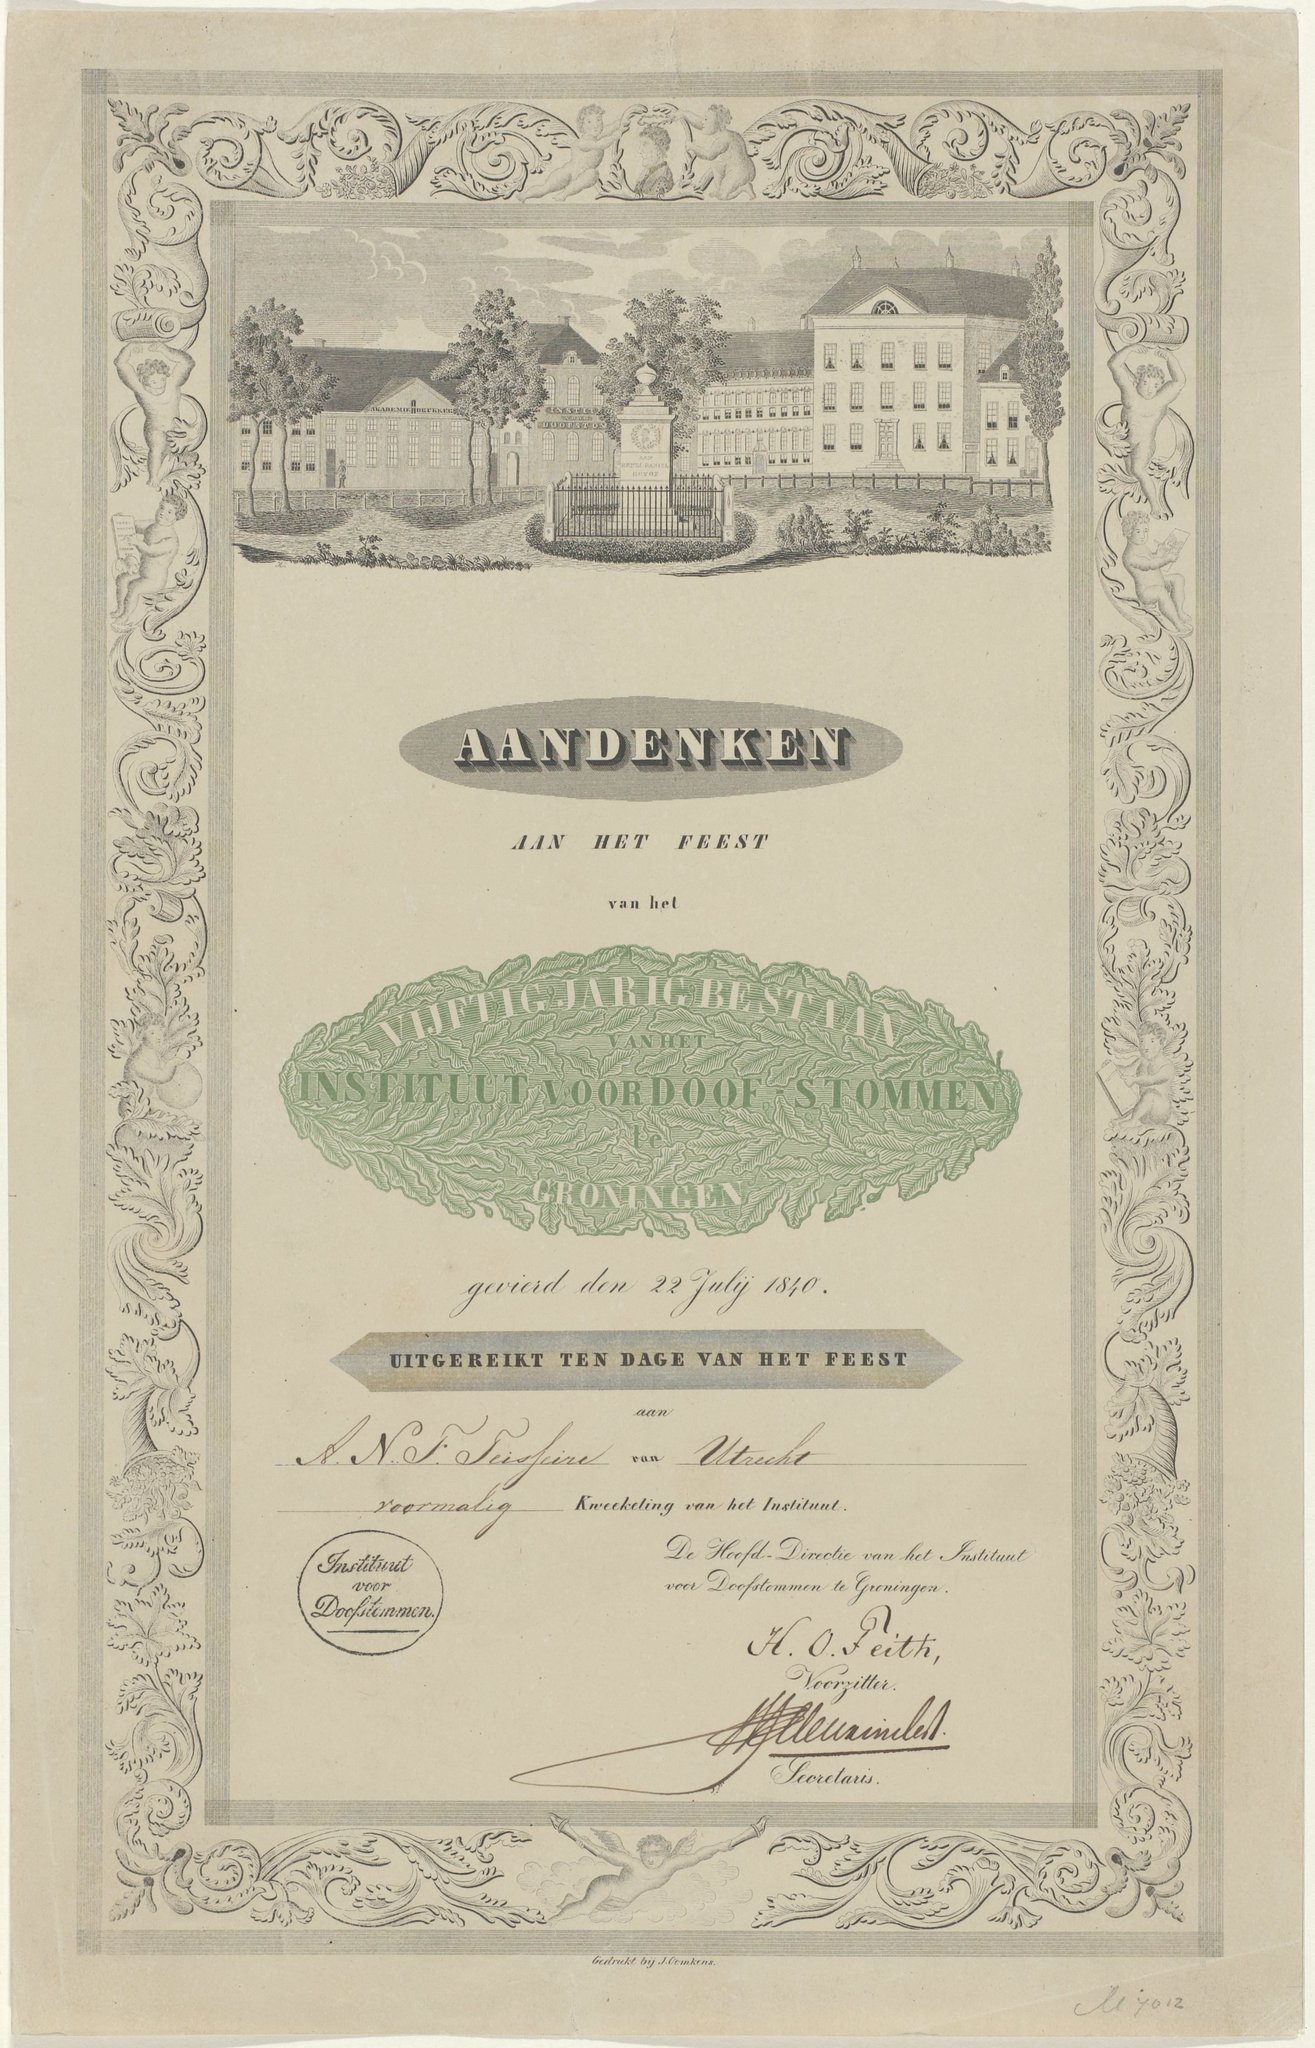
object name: print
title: Aandenken aan het feest van het vijftigjarig bestaan van het Instituut voor Doof-Stommen te Groningen gevierd den 22 Julij 1840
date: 1840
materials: paper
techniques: letterpress printing, lithograph, writing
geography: netherlands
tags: deaf, deafness, specialized institutions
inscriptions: collector's mark: Lugt 2228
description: Aandenken aan het feest van het vijftigjarig bestaan (1790-1840) van het Instituut voor Doofstommen (Henri Daniel Guyot Instituut) te Groningen, gevierd op 22 juli 1840. Herinneringsplaat uitgereikt aan de voormalige kweekelingen van het instituut, dit exemplaar op naam gesteld van A.N.F. Teisseire uit Utrecht. Bovenaan een gezicht op het instituut, met versierde omlijsting.